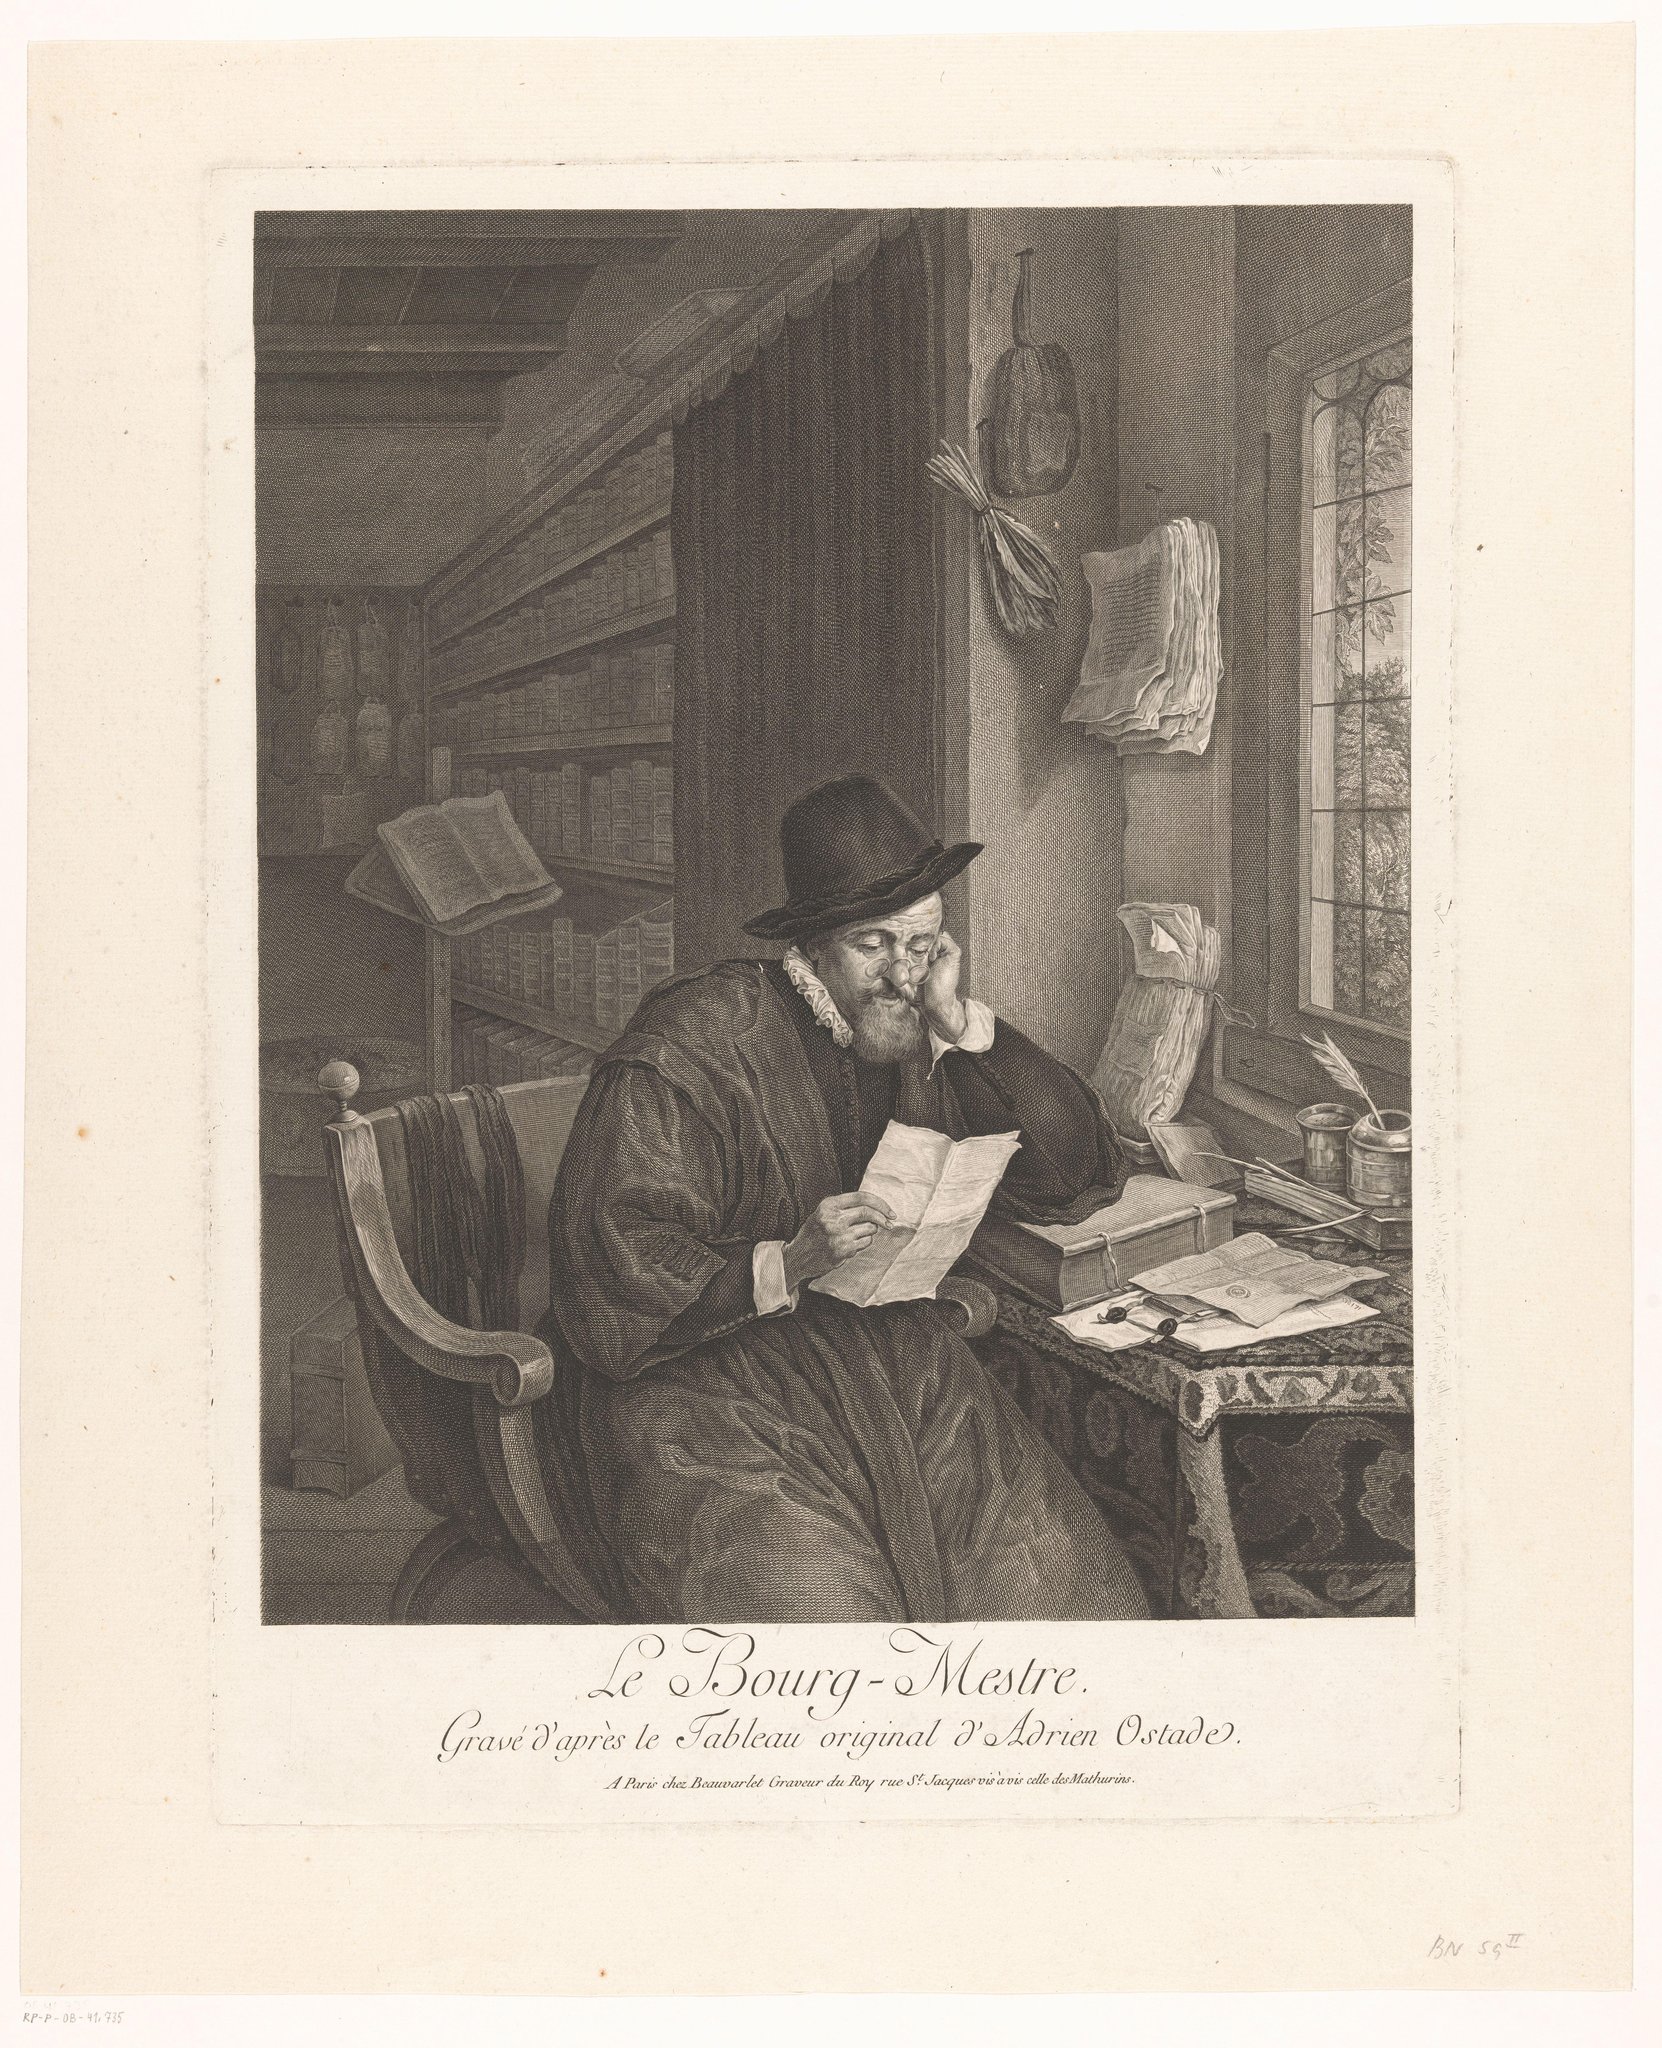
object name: print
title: Lezende burgemeester in zijn studeervertrek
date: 1741-1797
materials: paper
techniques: engraving, etching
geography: france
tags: reading, mayor, burgomaster, study; 'studiolo'; library, letter, envelope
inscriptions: collector's mark: Lugt 240